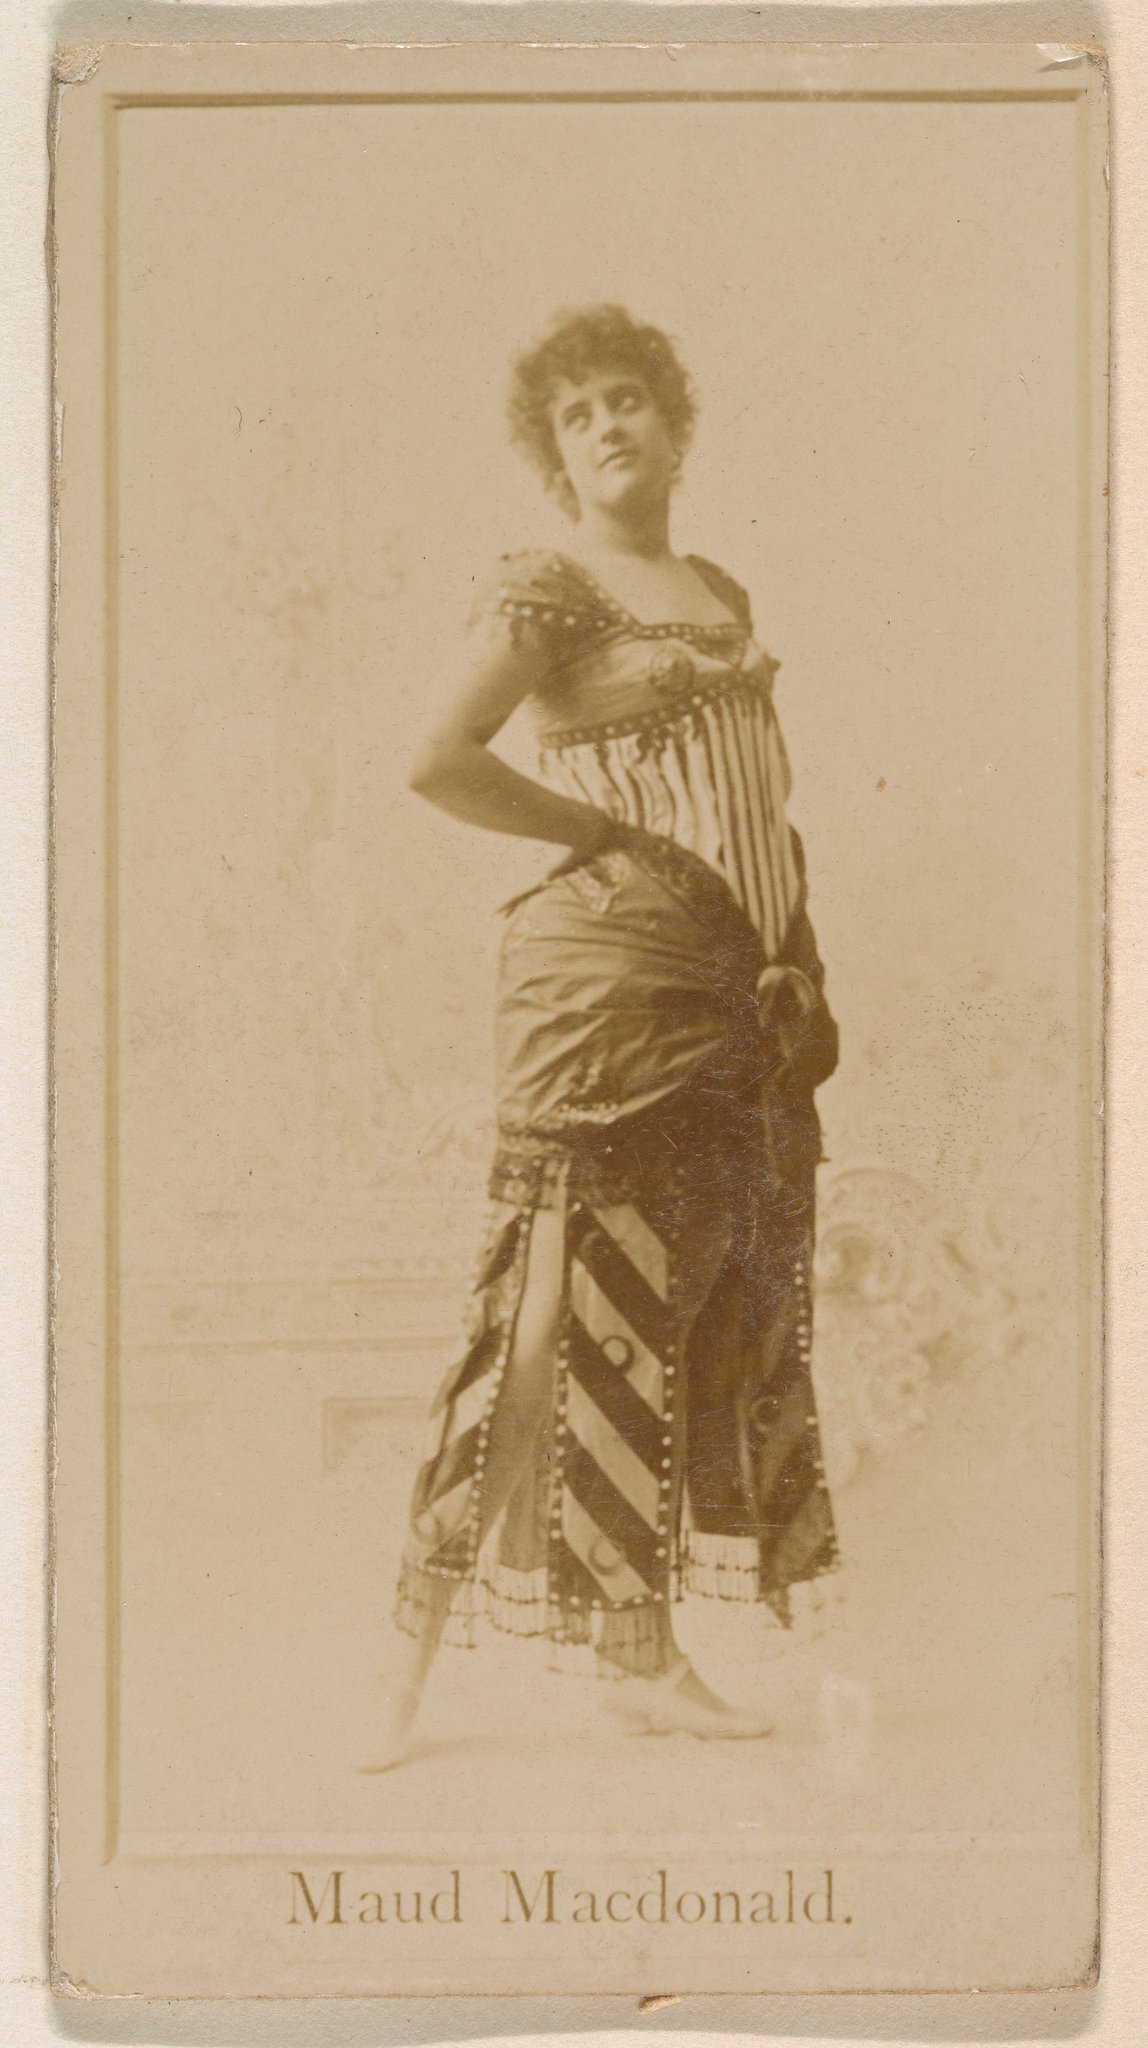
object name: photograph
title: Maud Macdonald, from the Actresses series (N245) issued by Kinney Brothers to promote Sweet Caporal Cigarettes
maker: kinney brothers tobacco company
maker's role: publisher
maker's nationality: american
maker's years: 1869-2011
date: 1890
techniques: albumen silver print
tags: portraits,women,actresses